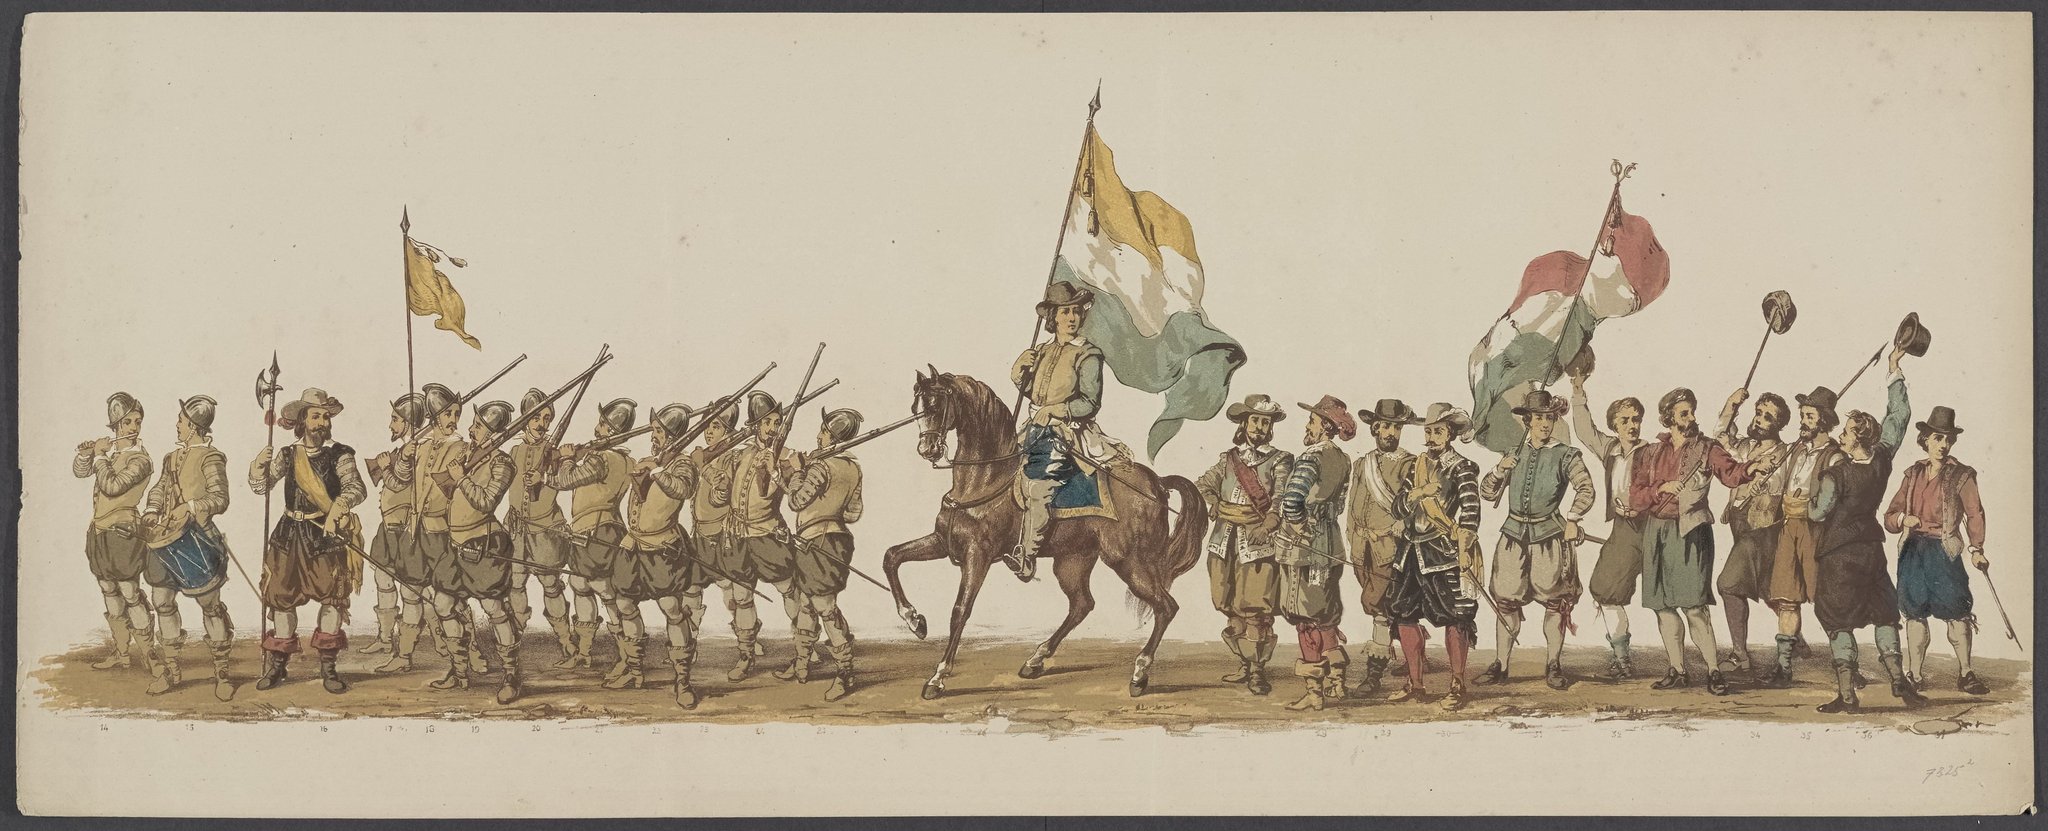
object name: print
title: Vierde Lustrum der Koninklijke Academie te Delft - Ao. 1862 - Gekostumeerde Optogt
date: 1862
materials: paper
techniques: chromolithography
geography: netherlands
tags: students' pageant, costumes used in pageants, commemoration of the founding of a university, delft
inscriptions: collector's mark: Lugt 2228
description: Eerste en tweede groep: soldaten van het Staatse leger, vaandeldrager te paard en matrozen, genummerd 14-37. Onderdeel van de serie van acht platen van de gekostumeerde optocht gehouden door de studenten van de Koninklijke Academie te Delft bij het vierde lustrum op 8 juni 1862, plus intekenlijst en ledenlijst. De stoet stelt voor het gezantschap van de sultan van Atjeh aan prins Maurits en de Staten op 4 september 1602.